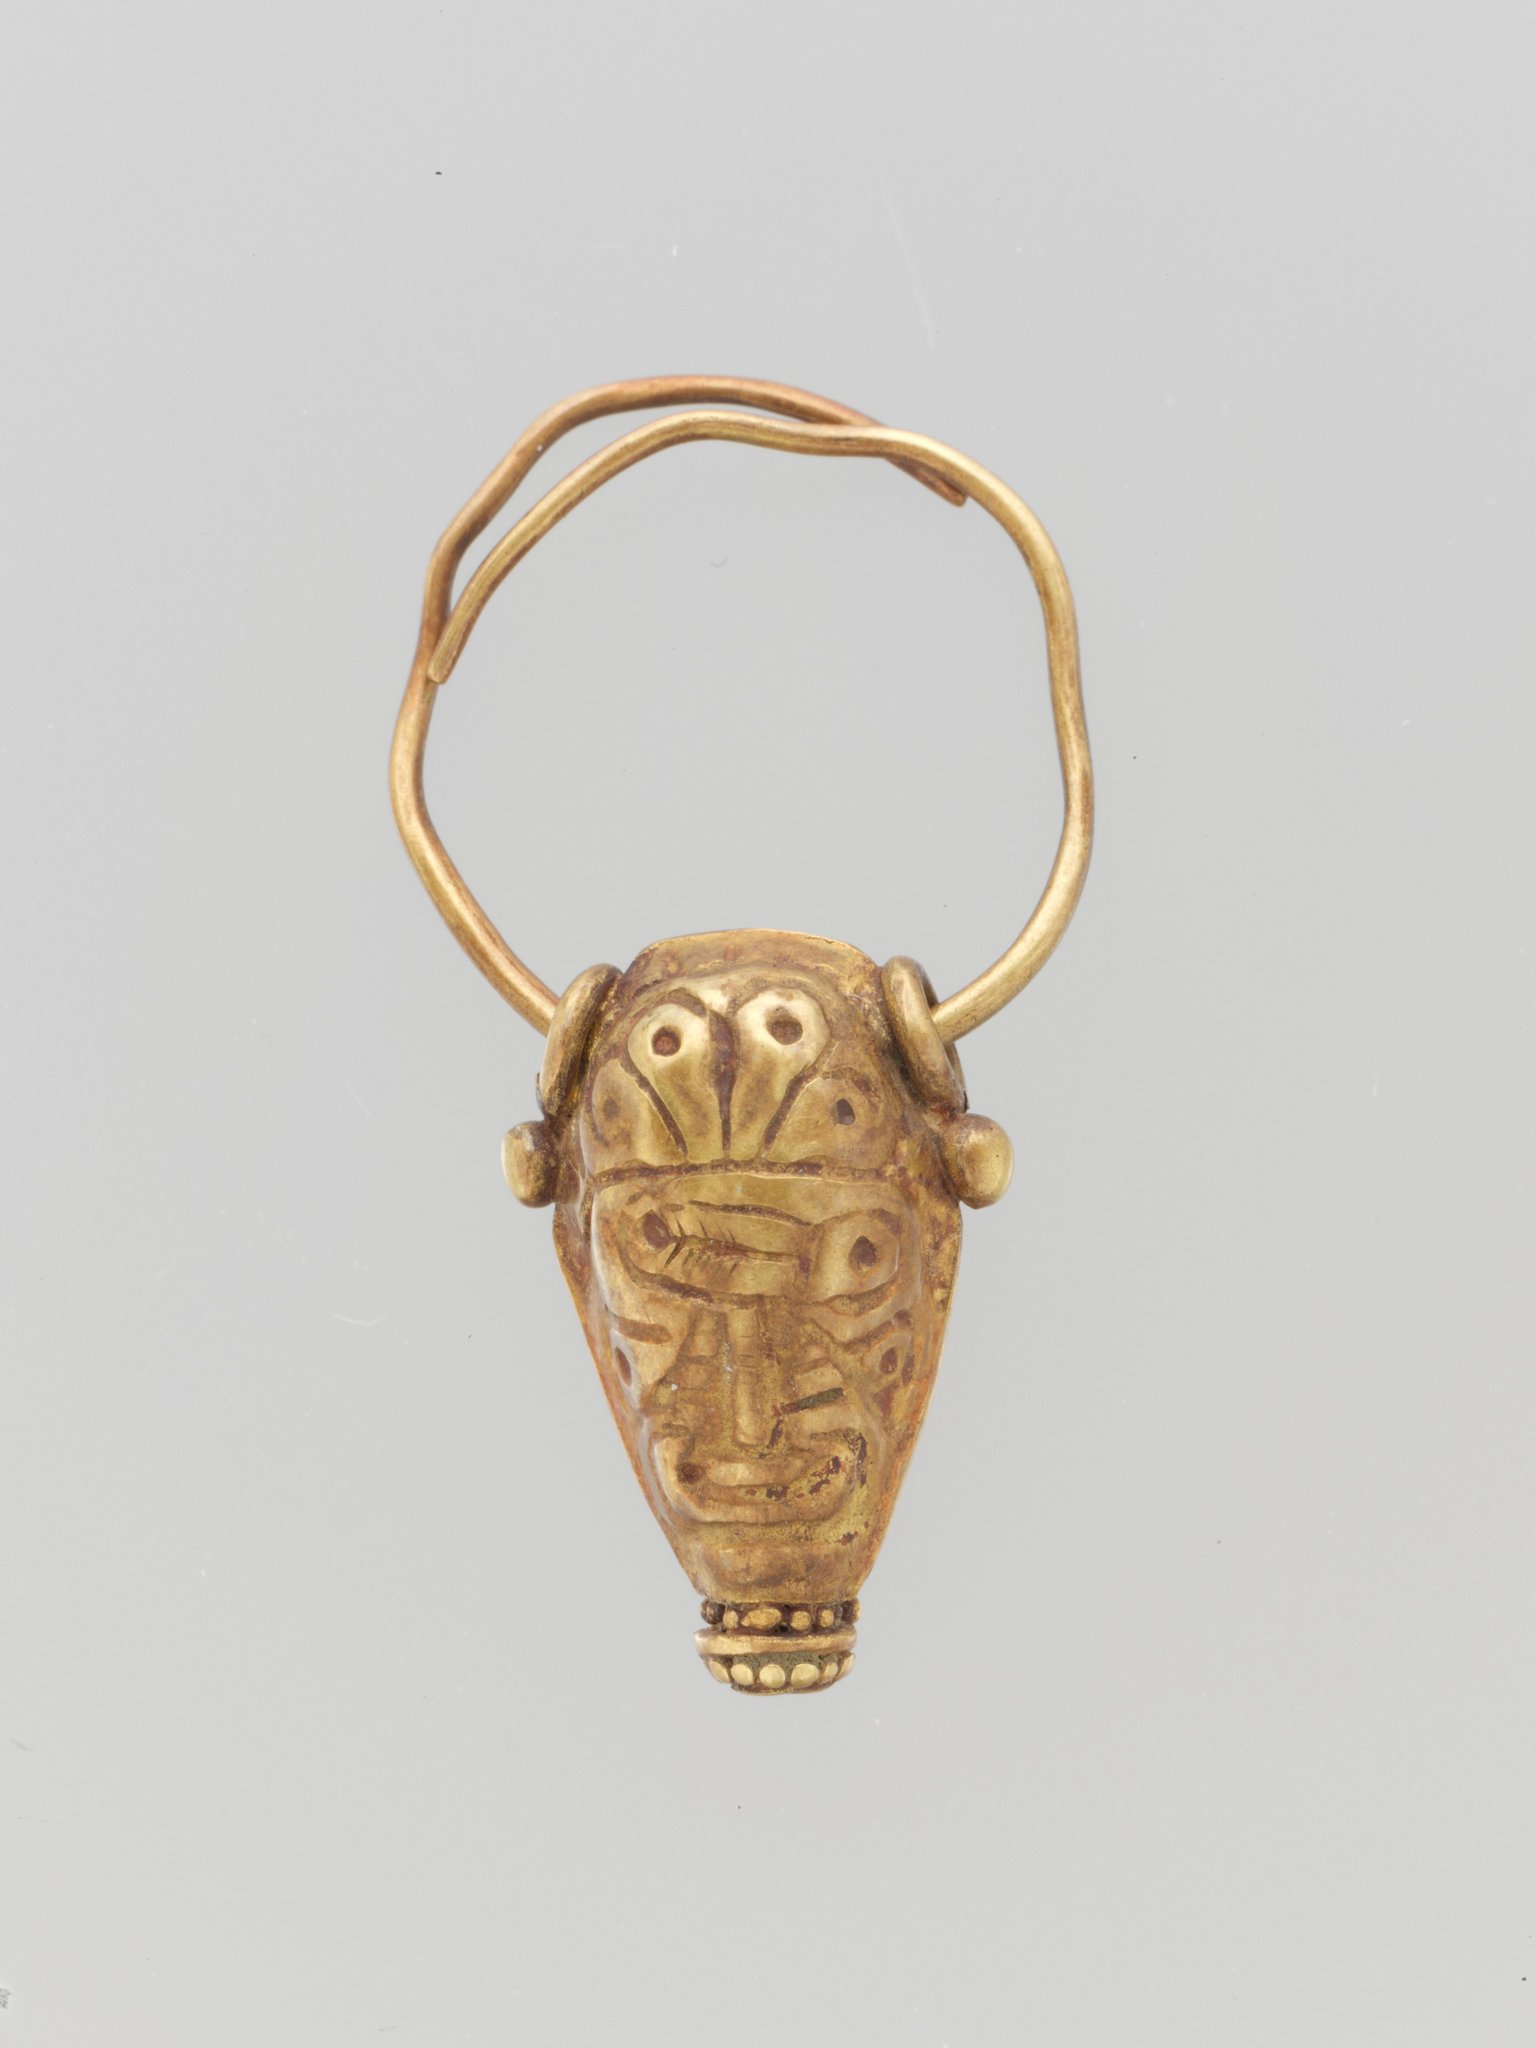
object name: earring with head of bull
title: Gold earring with head of a bull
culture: cypriot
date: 1400-1050 BCE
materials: gold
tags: bulls